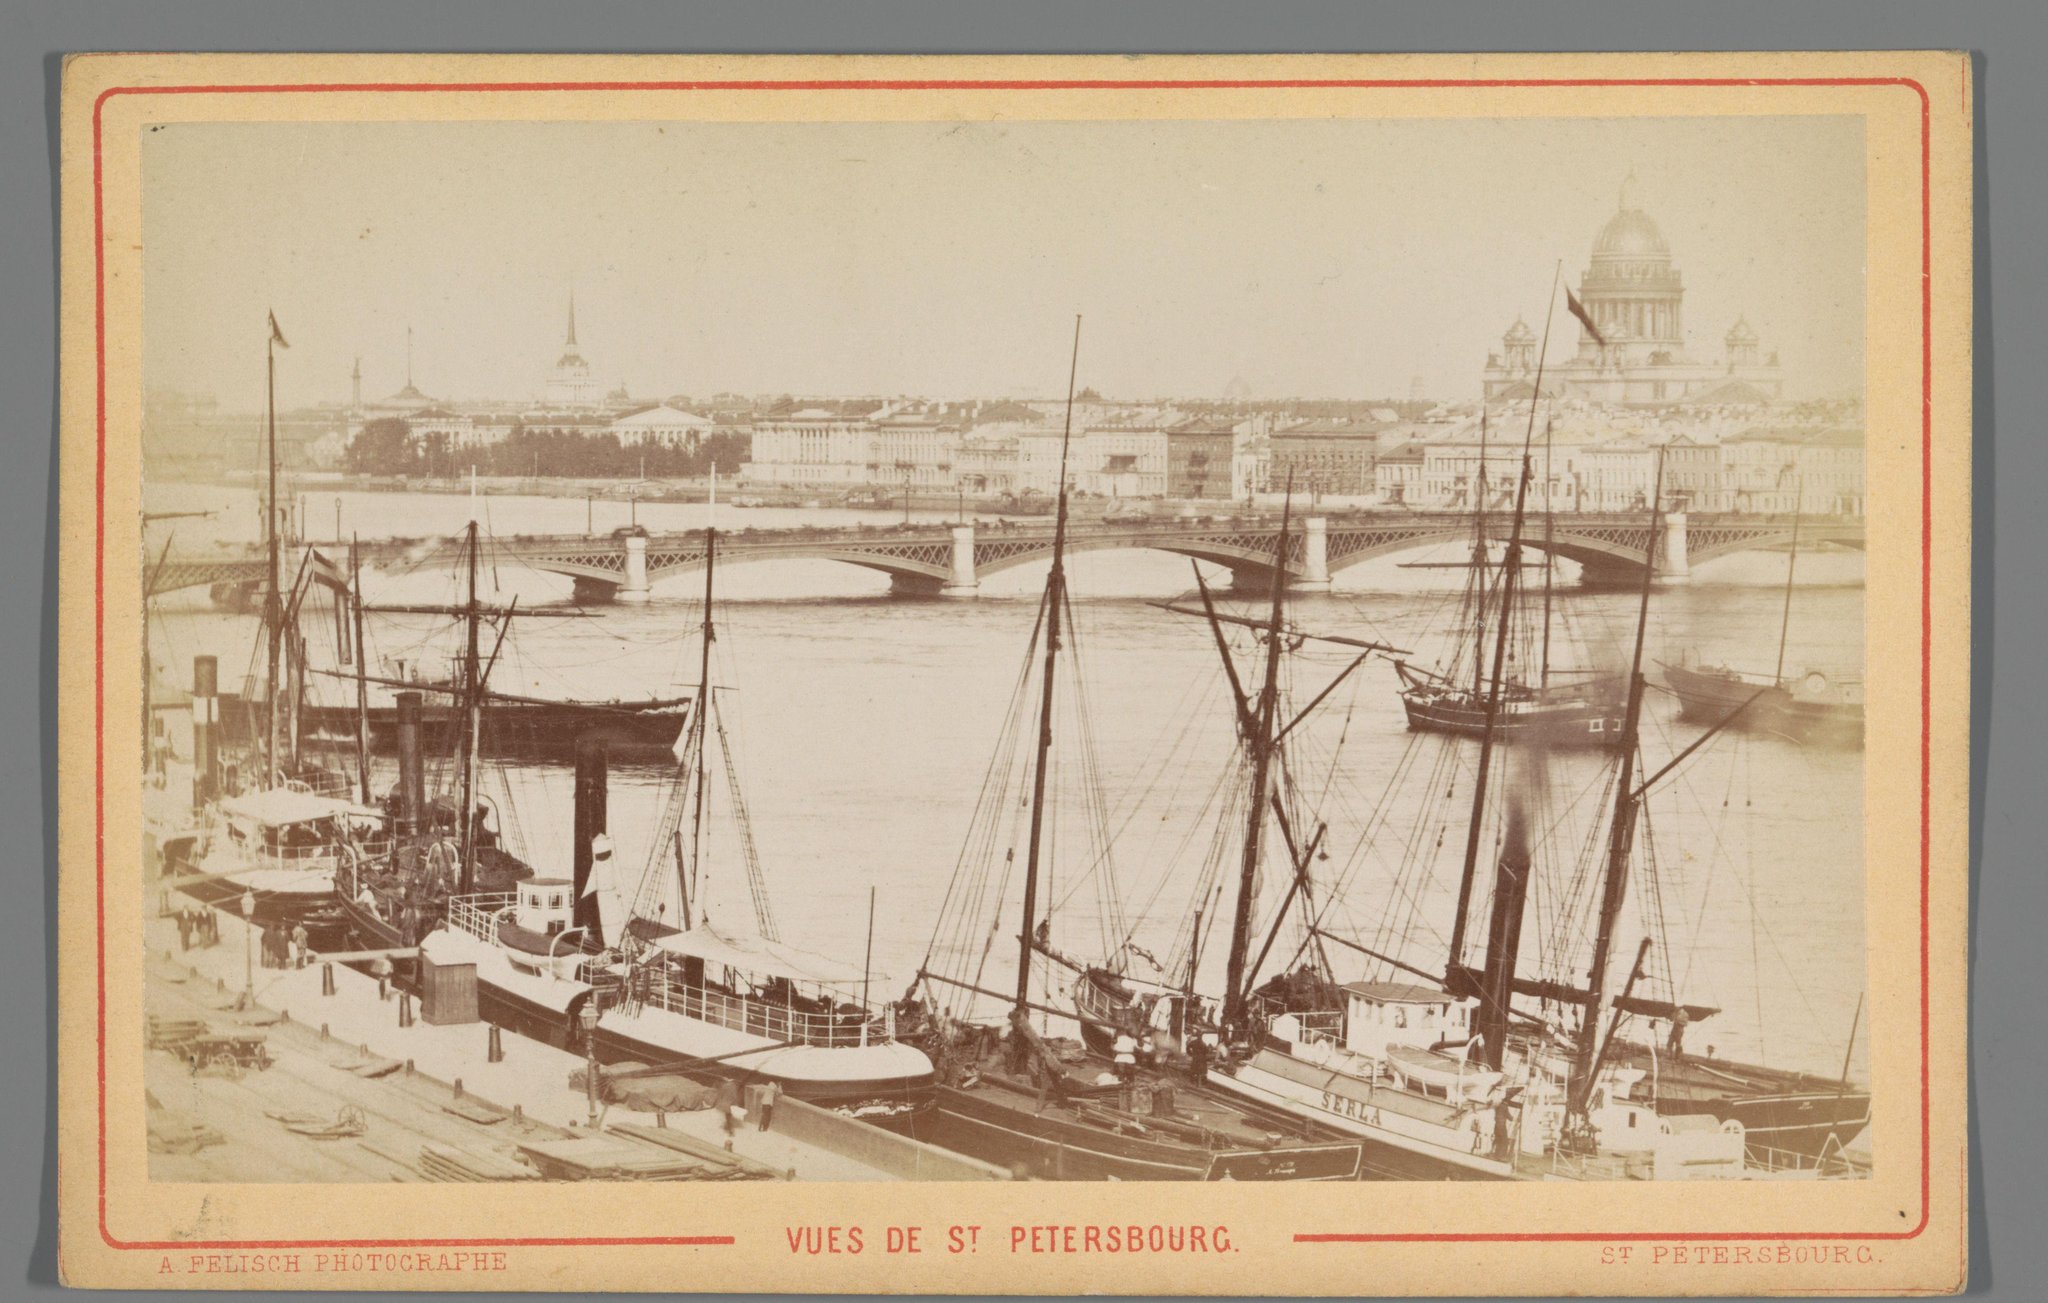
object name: photograph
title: Gezicht op de Nicolaasbrug over de Neva in Sint-Petersburg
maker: albert felisch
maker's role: fotograaf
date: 1880-1900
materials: cardboard, photographic support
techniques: albumen print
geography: sint-petersburg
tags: ships (in general), bridge in city across river, canal, etc.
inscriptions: inscription: ‘Panorama de la Neva et Pont Nicolas’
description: Onderdeel van Fotoalbum met opnames van Sint-Petersburg.